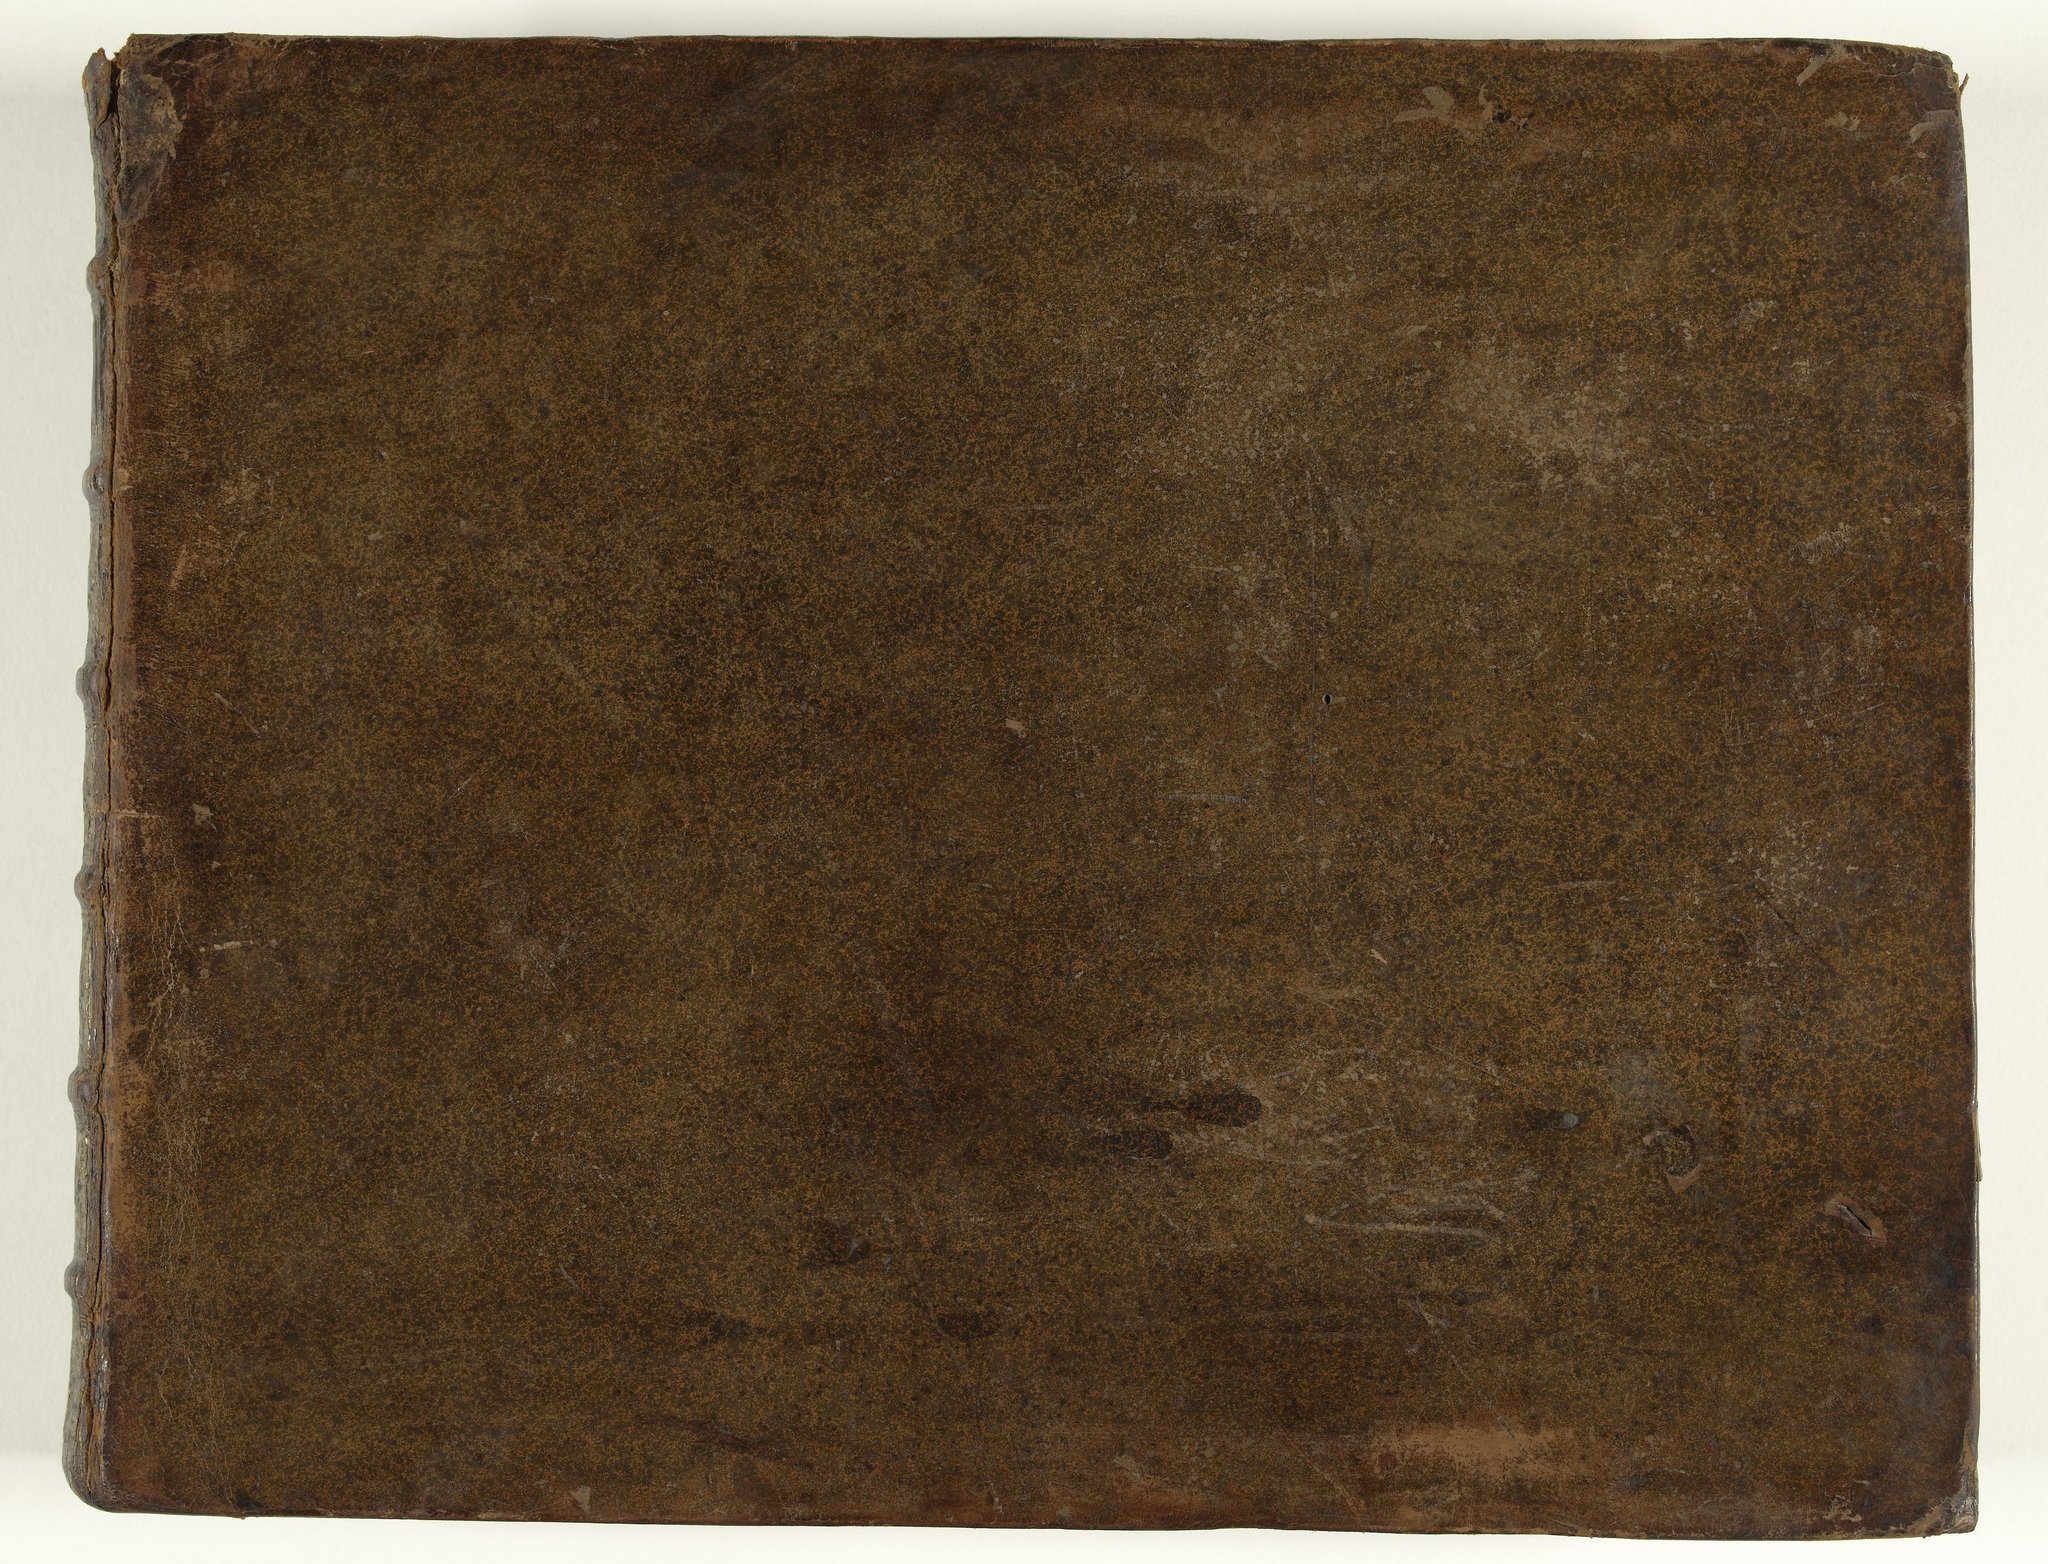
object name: album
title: Verzamelband met het prentwerk: Les Forces de l'Europe, Asie, Afrique et Amerique (...) Comme aussi les Cartes des Côtes de France et d'Espagne, delen XI-XX, 1726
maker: pieter van der aa (i)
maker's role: printer, publisher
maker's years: 1659-1733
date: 1726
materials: leather, paper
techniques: engraving, etching, letterpress printing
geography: leiden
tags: fortress, maps of separate countries or regions, maps of cities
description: Verzamelband waarin zijn samengebonden de laatste tien delen van het prentwerk: Les Forces de l'Europe, Asie, Afrique et Amerique ... Comme aussi les Cartes des Côtes de France et d'Espagne. Vermeerderde heruitgave van het album van Pieter Mortier uit ca. 1702 nu samengesteld en uitgegeven door Pieter van der Aa in twee delen in 1726. In een boekband van leer met de titel op de rug. De 271 platen in dit tweede deel zijn met de hand genummerd 239-509. Voor het merendeel zijn deze platen gekopieerd naar de anonieme Franse platen van vermaarde sterke steden en vestingen: in Les forces de l'Europe en in: Le theatre de la guerre, dans les Pays-Bas, beide oorspronkelijk uitgegeven door Nicolas de Fer te Parijs (1693-1697) in het kader van de Negenjarige Oorlog. Hieraan zijn veel nieuwe platen toegevoegd, sommige met voorstellingen van gebeurtenissen uit de Spaanse Successieoorlog. Titels en opschriften in het Frans.